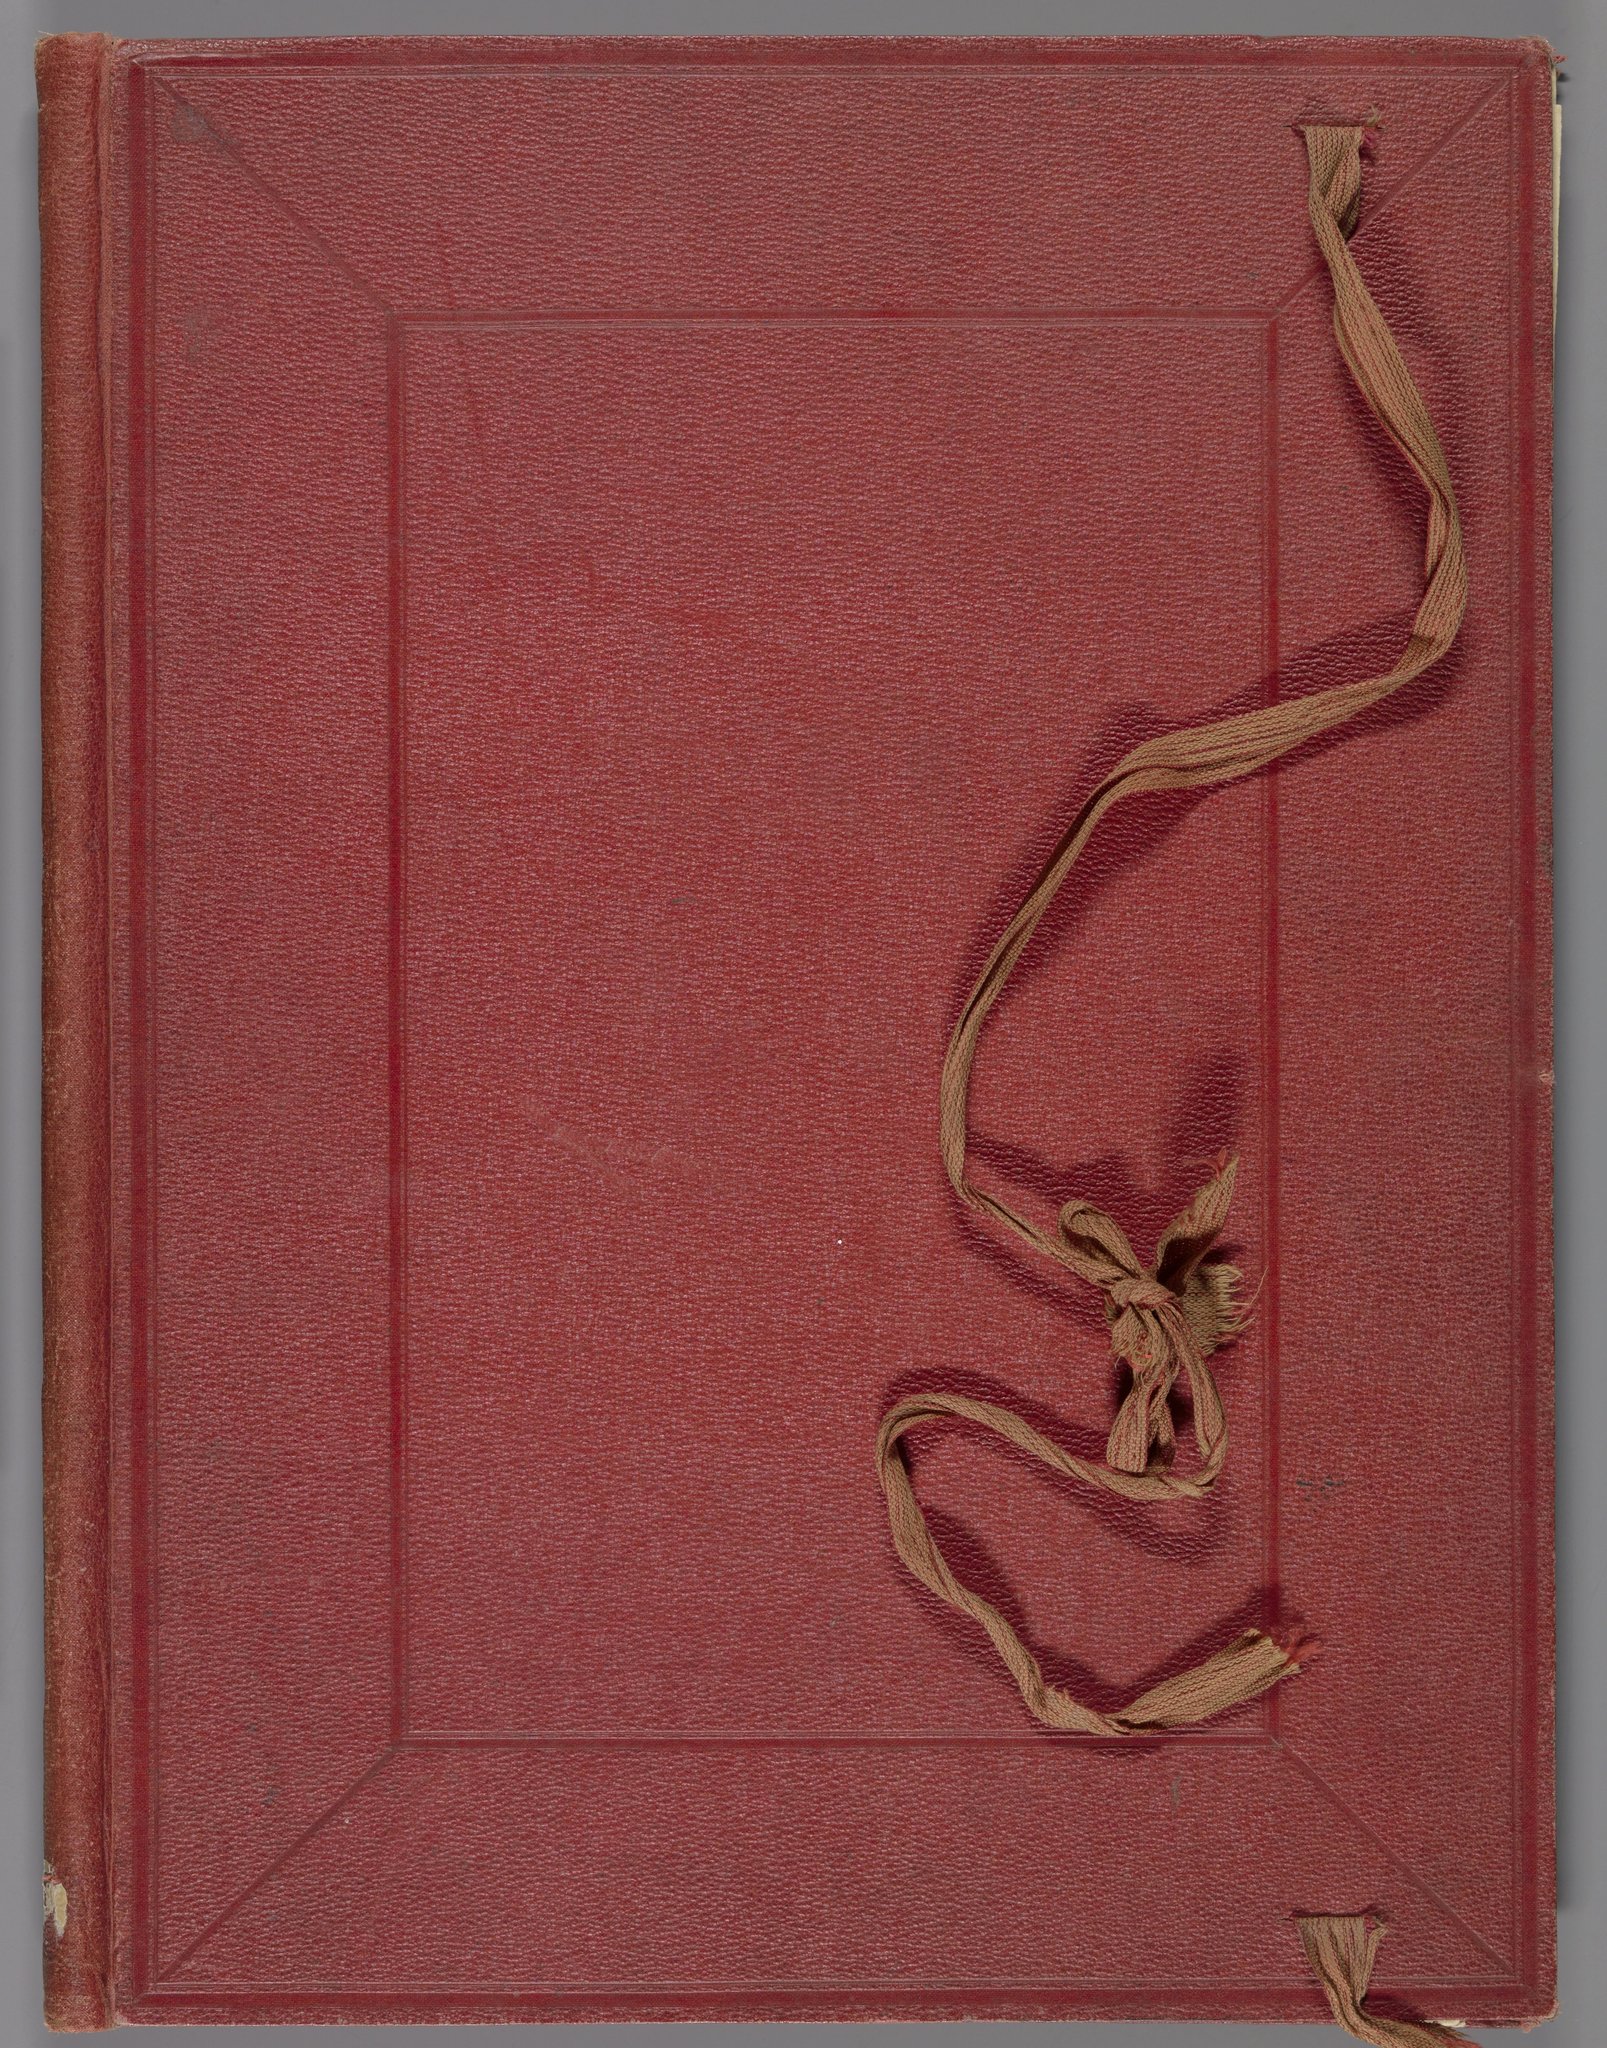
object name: prentrecueil, prentenalbum, prentalbum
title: Portefeuille met de etsen van John Chalon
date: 1748-1795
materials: linen, leather, paper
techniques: bookbinding, drypoint, etching, letterpress printing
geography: london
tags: morphology of human expression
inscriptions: collector's mark: ‘RIJKS / MUSM’, collector's mark: ‘B’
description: Portefeuille met een titelpagina en 96 voorstellingen op 40 losse bladen. Het gaat om afbeeldingen van allerlei mannen en vrouwen geëtst naar eigen ontwerp door Jan Chalon. Rood marokijnen band.